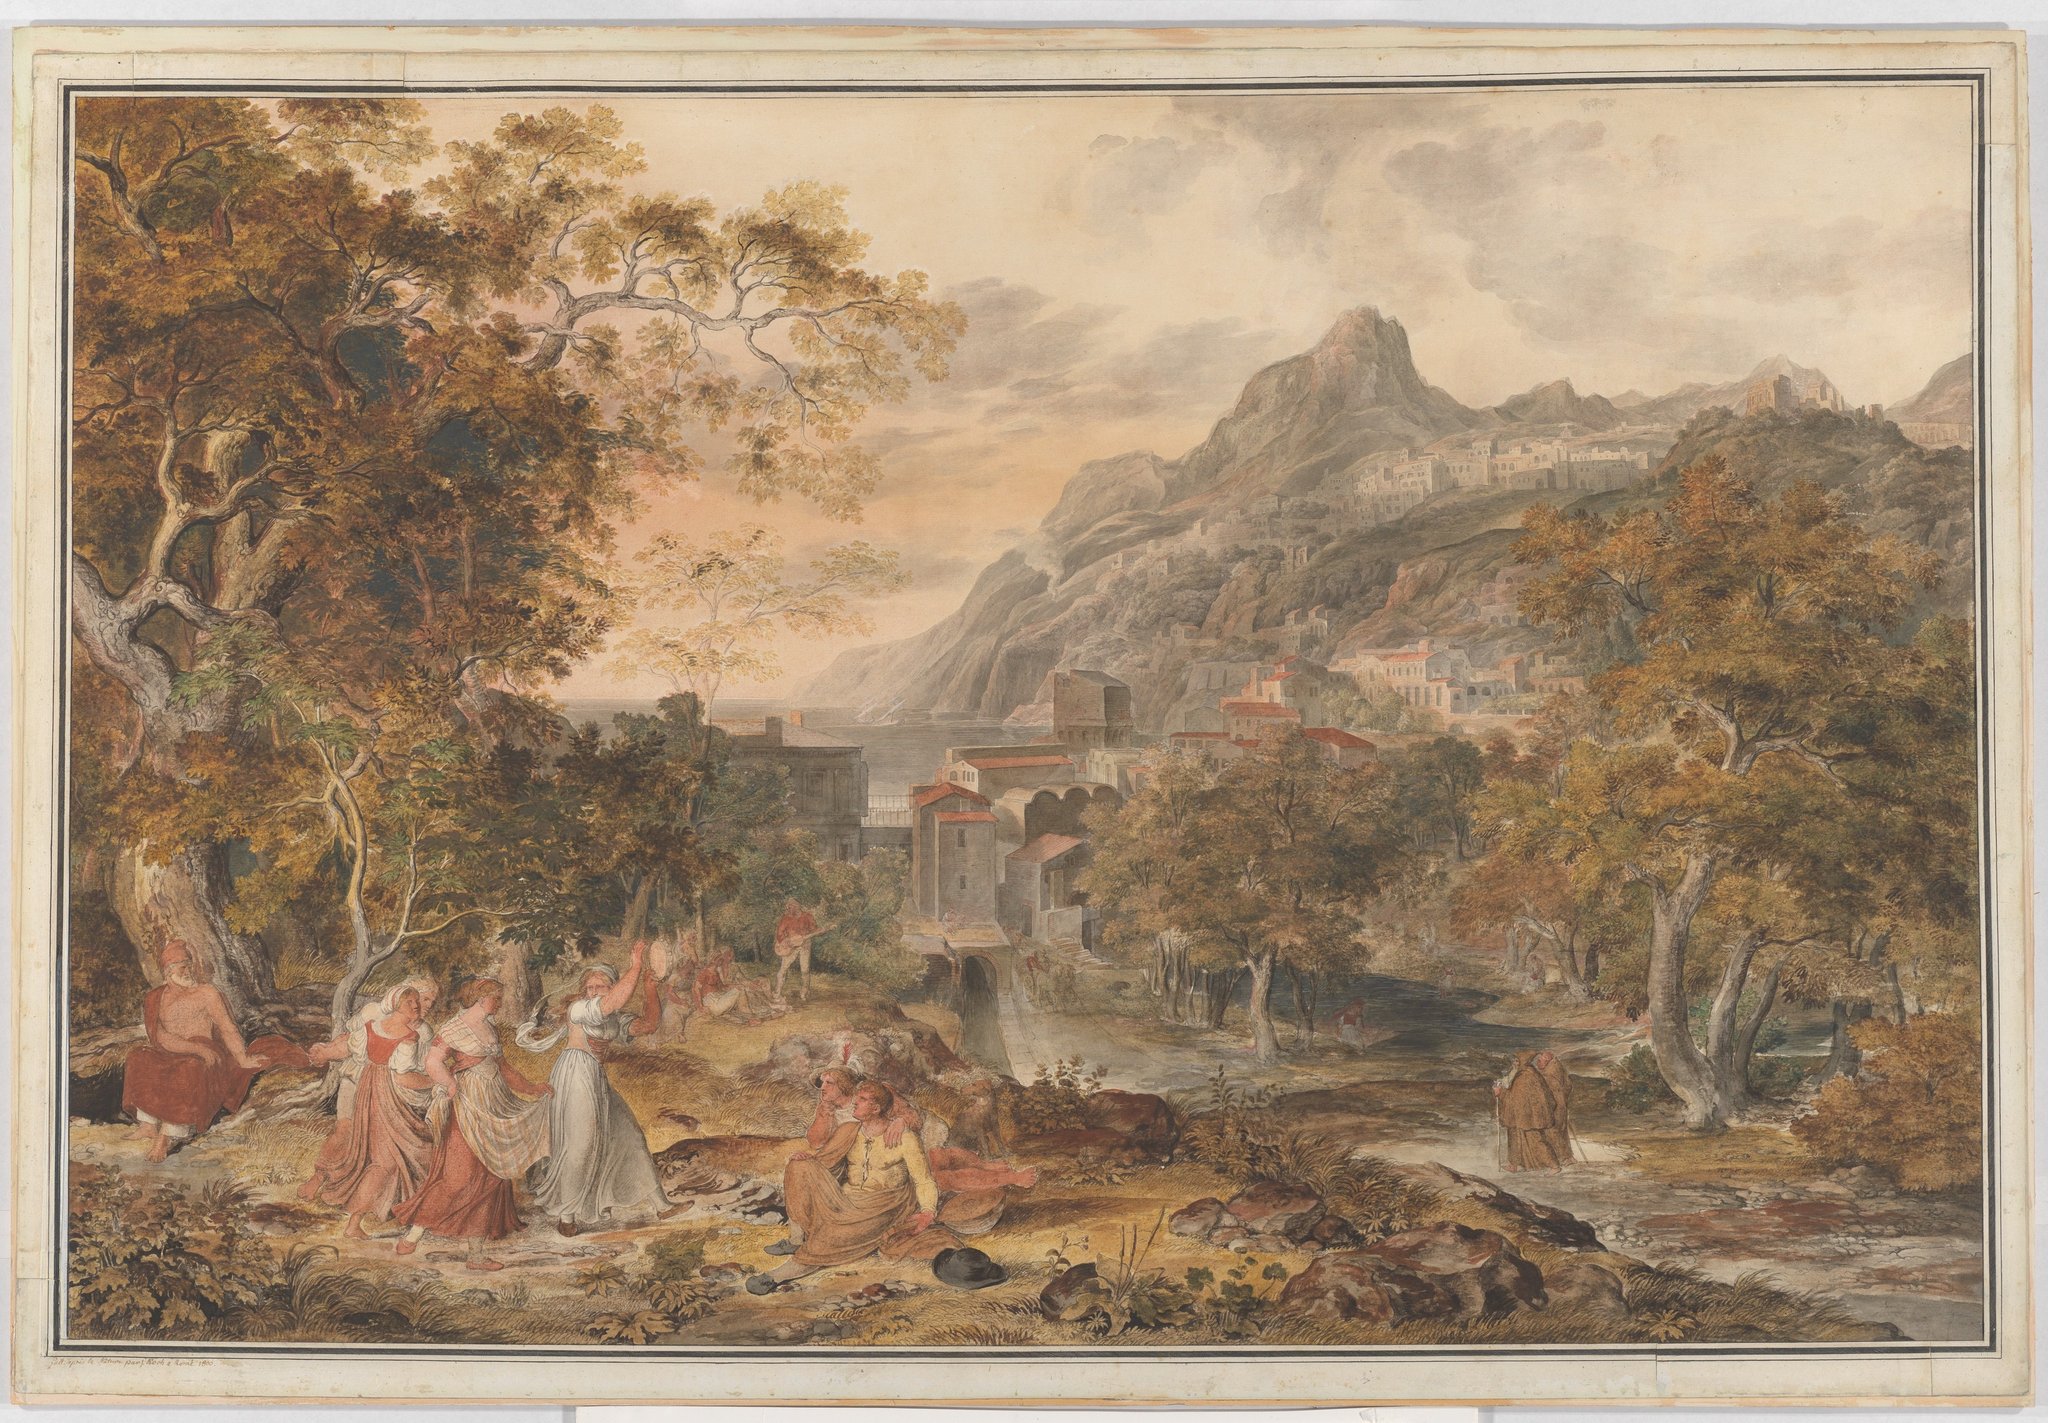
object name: drawing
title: View of Vietri with Young Country Women Dancing for Shepherds in the Foreground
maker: joseph anton koch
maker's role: artist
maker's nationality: austrian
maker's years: 1768-1839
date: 1800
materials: chalk, gouache, ink, watercolor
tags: women,dancing,mountains,landscapes,shepherds